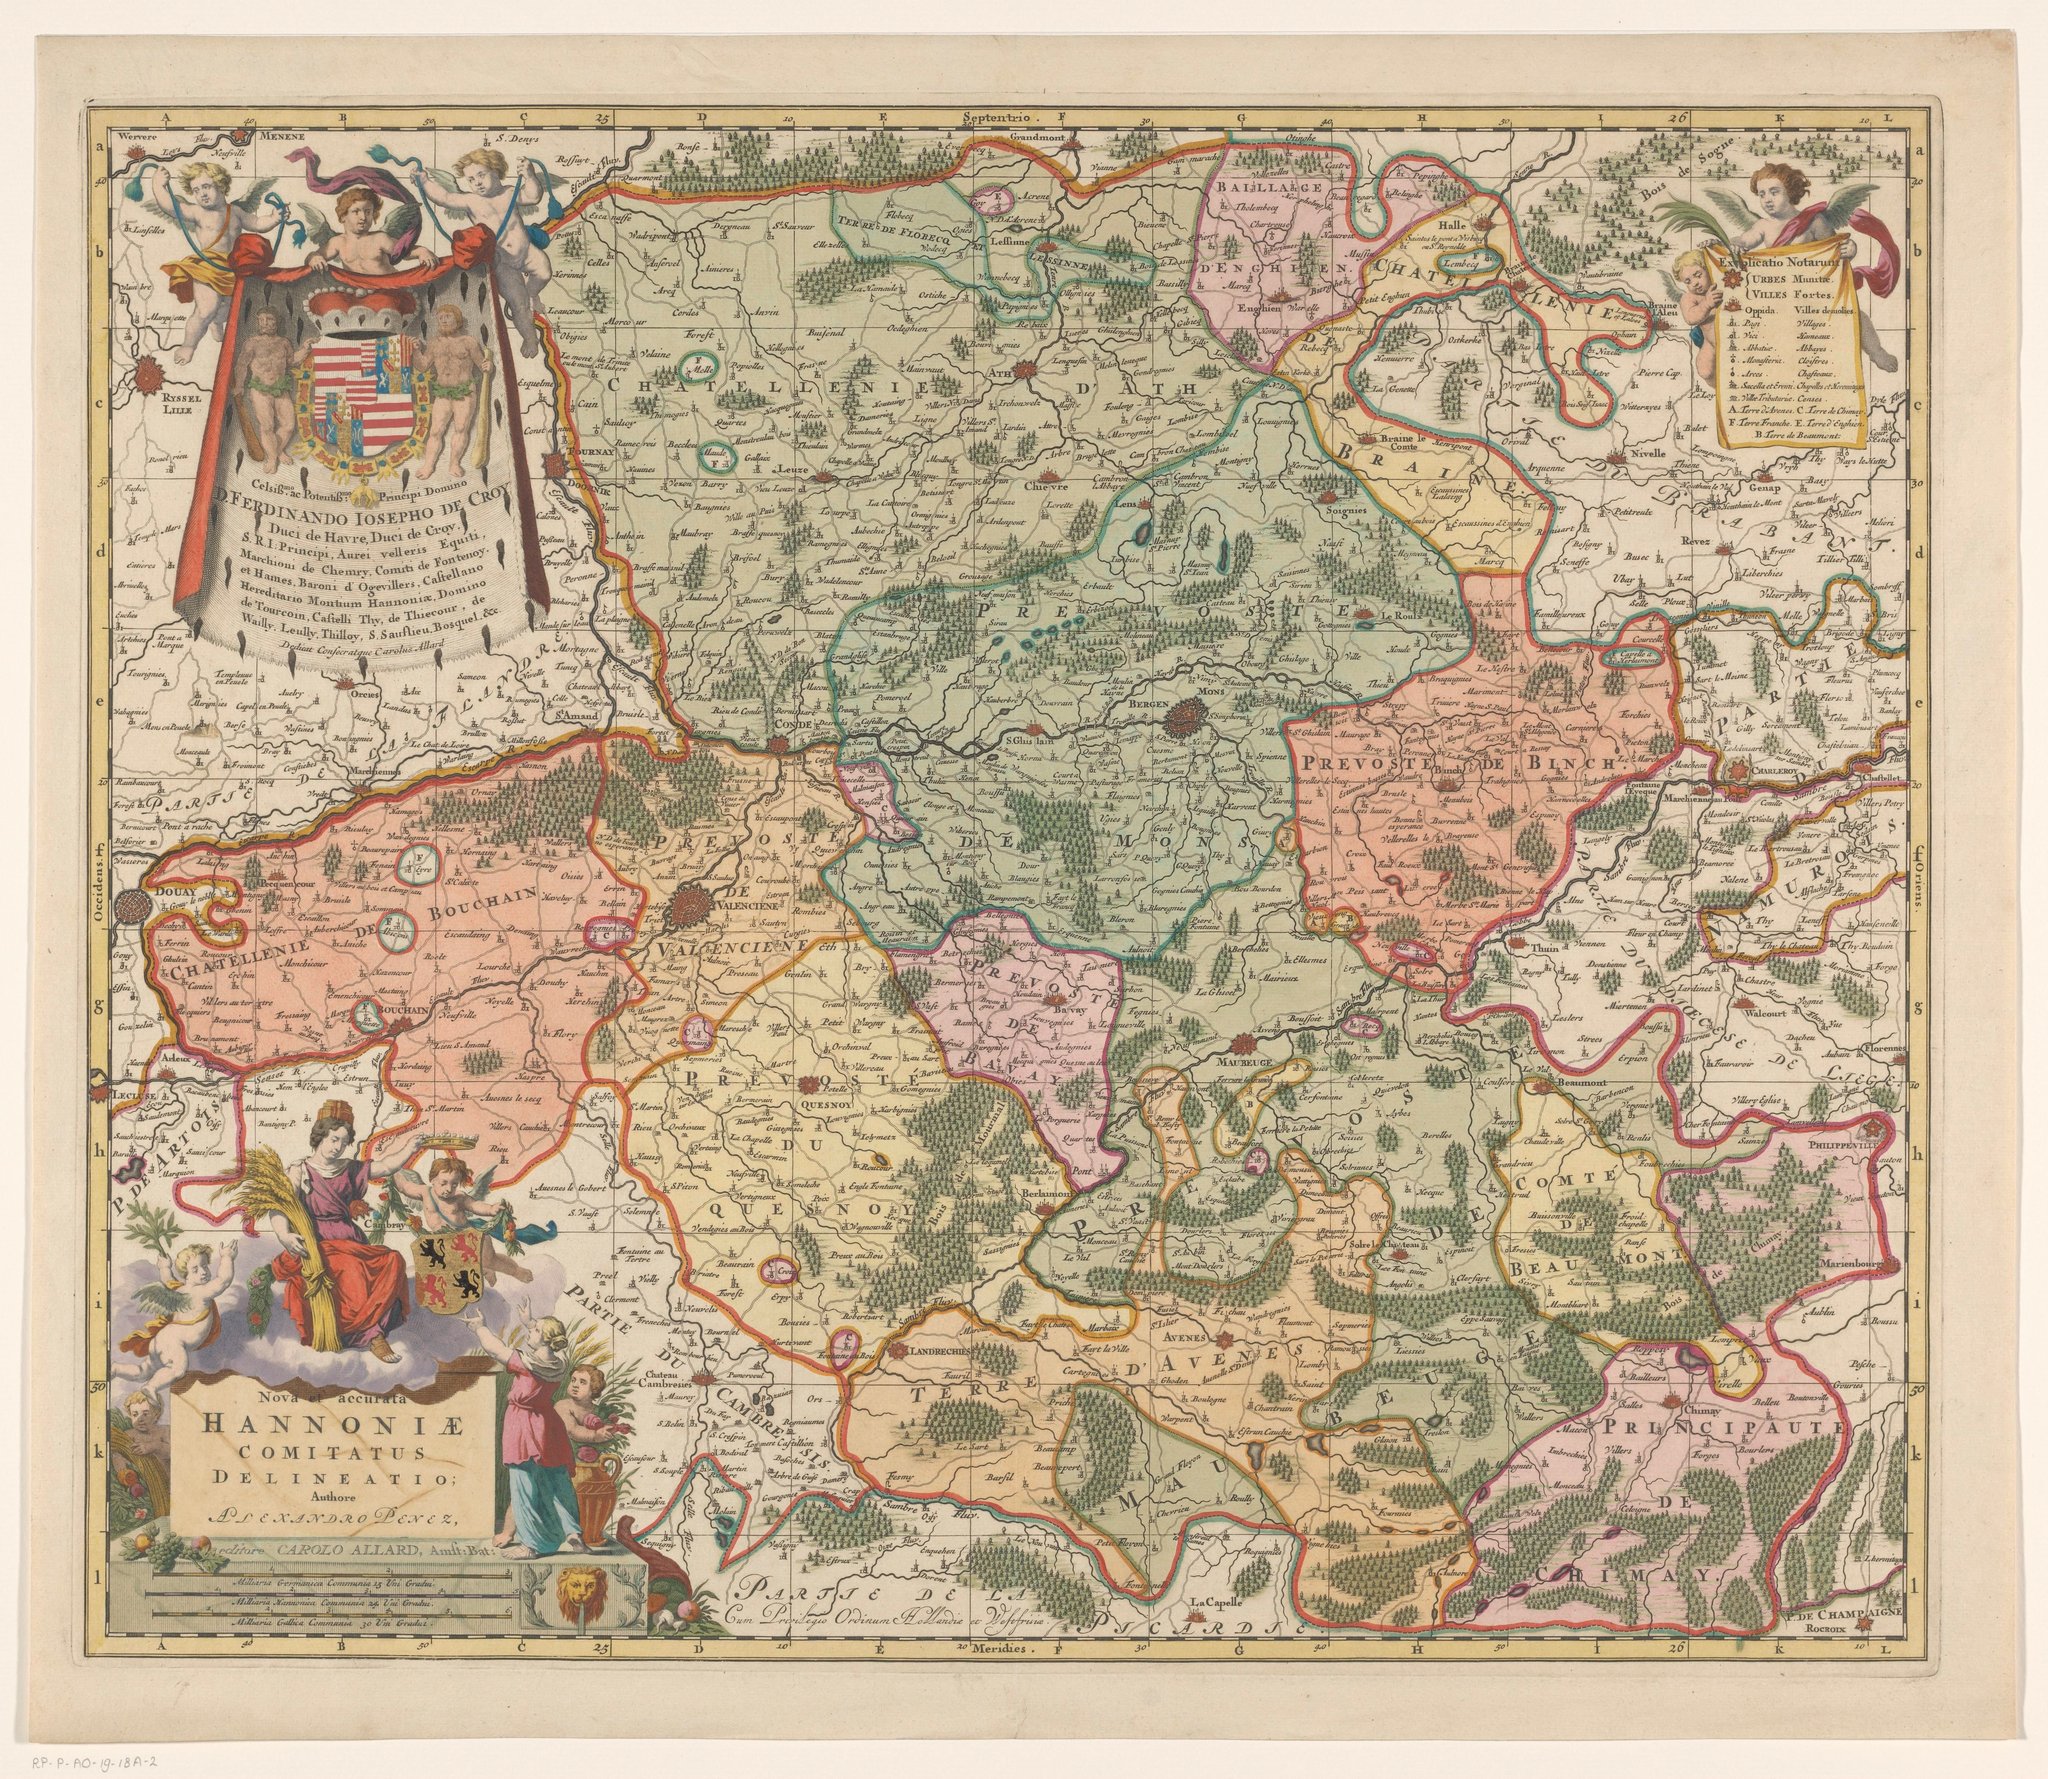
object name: map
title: Kaart van Henegouwen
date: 1675-1794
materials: paper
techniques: engraving, etching, hand coloring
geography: amsterdam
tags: fruitfulness, productiveness, fertility, fecundity; 'fecondità' (ripa) (+ allegorical scene, i.e. two or more personifications involved in an action), maps of separate countries or regions, coat of arms (as symbol of the state, etc.) (+ province; provincial), armorial bearing, heraldry, henegouwen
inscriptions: collector's mark: Lugt 2228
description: Kaart van Henegouwen. Linksonder de titelcartouche met onderin drie schaalstokken: 3 Milliaria Germanica Communia 15 Uni Gradui / 5 Milliaria Hannonica Communia 24 Uni Gradui / 6 Milliaria Gallica Communia 30 Uni Gradui. Om de cartouche verschillende symbolen van vruchtbaarheid en een putto met het wapenschild van Henegouwen. Linksboven een cartouche met opdracht en het wapen van Ferdinand Francois Joseph de Croy. Rechtsboven een legenda. De kaart is voorzien van een coördinaten-net en een gradenverdeling langs de randen.